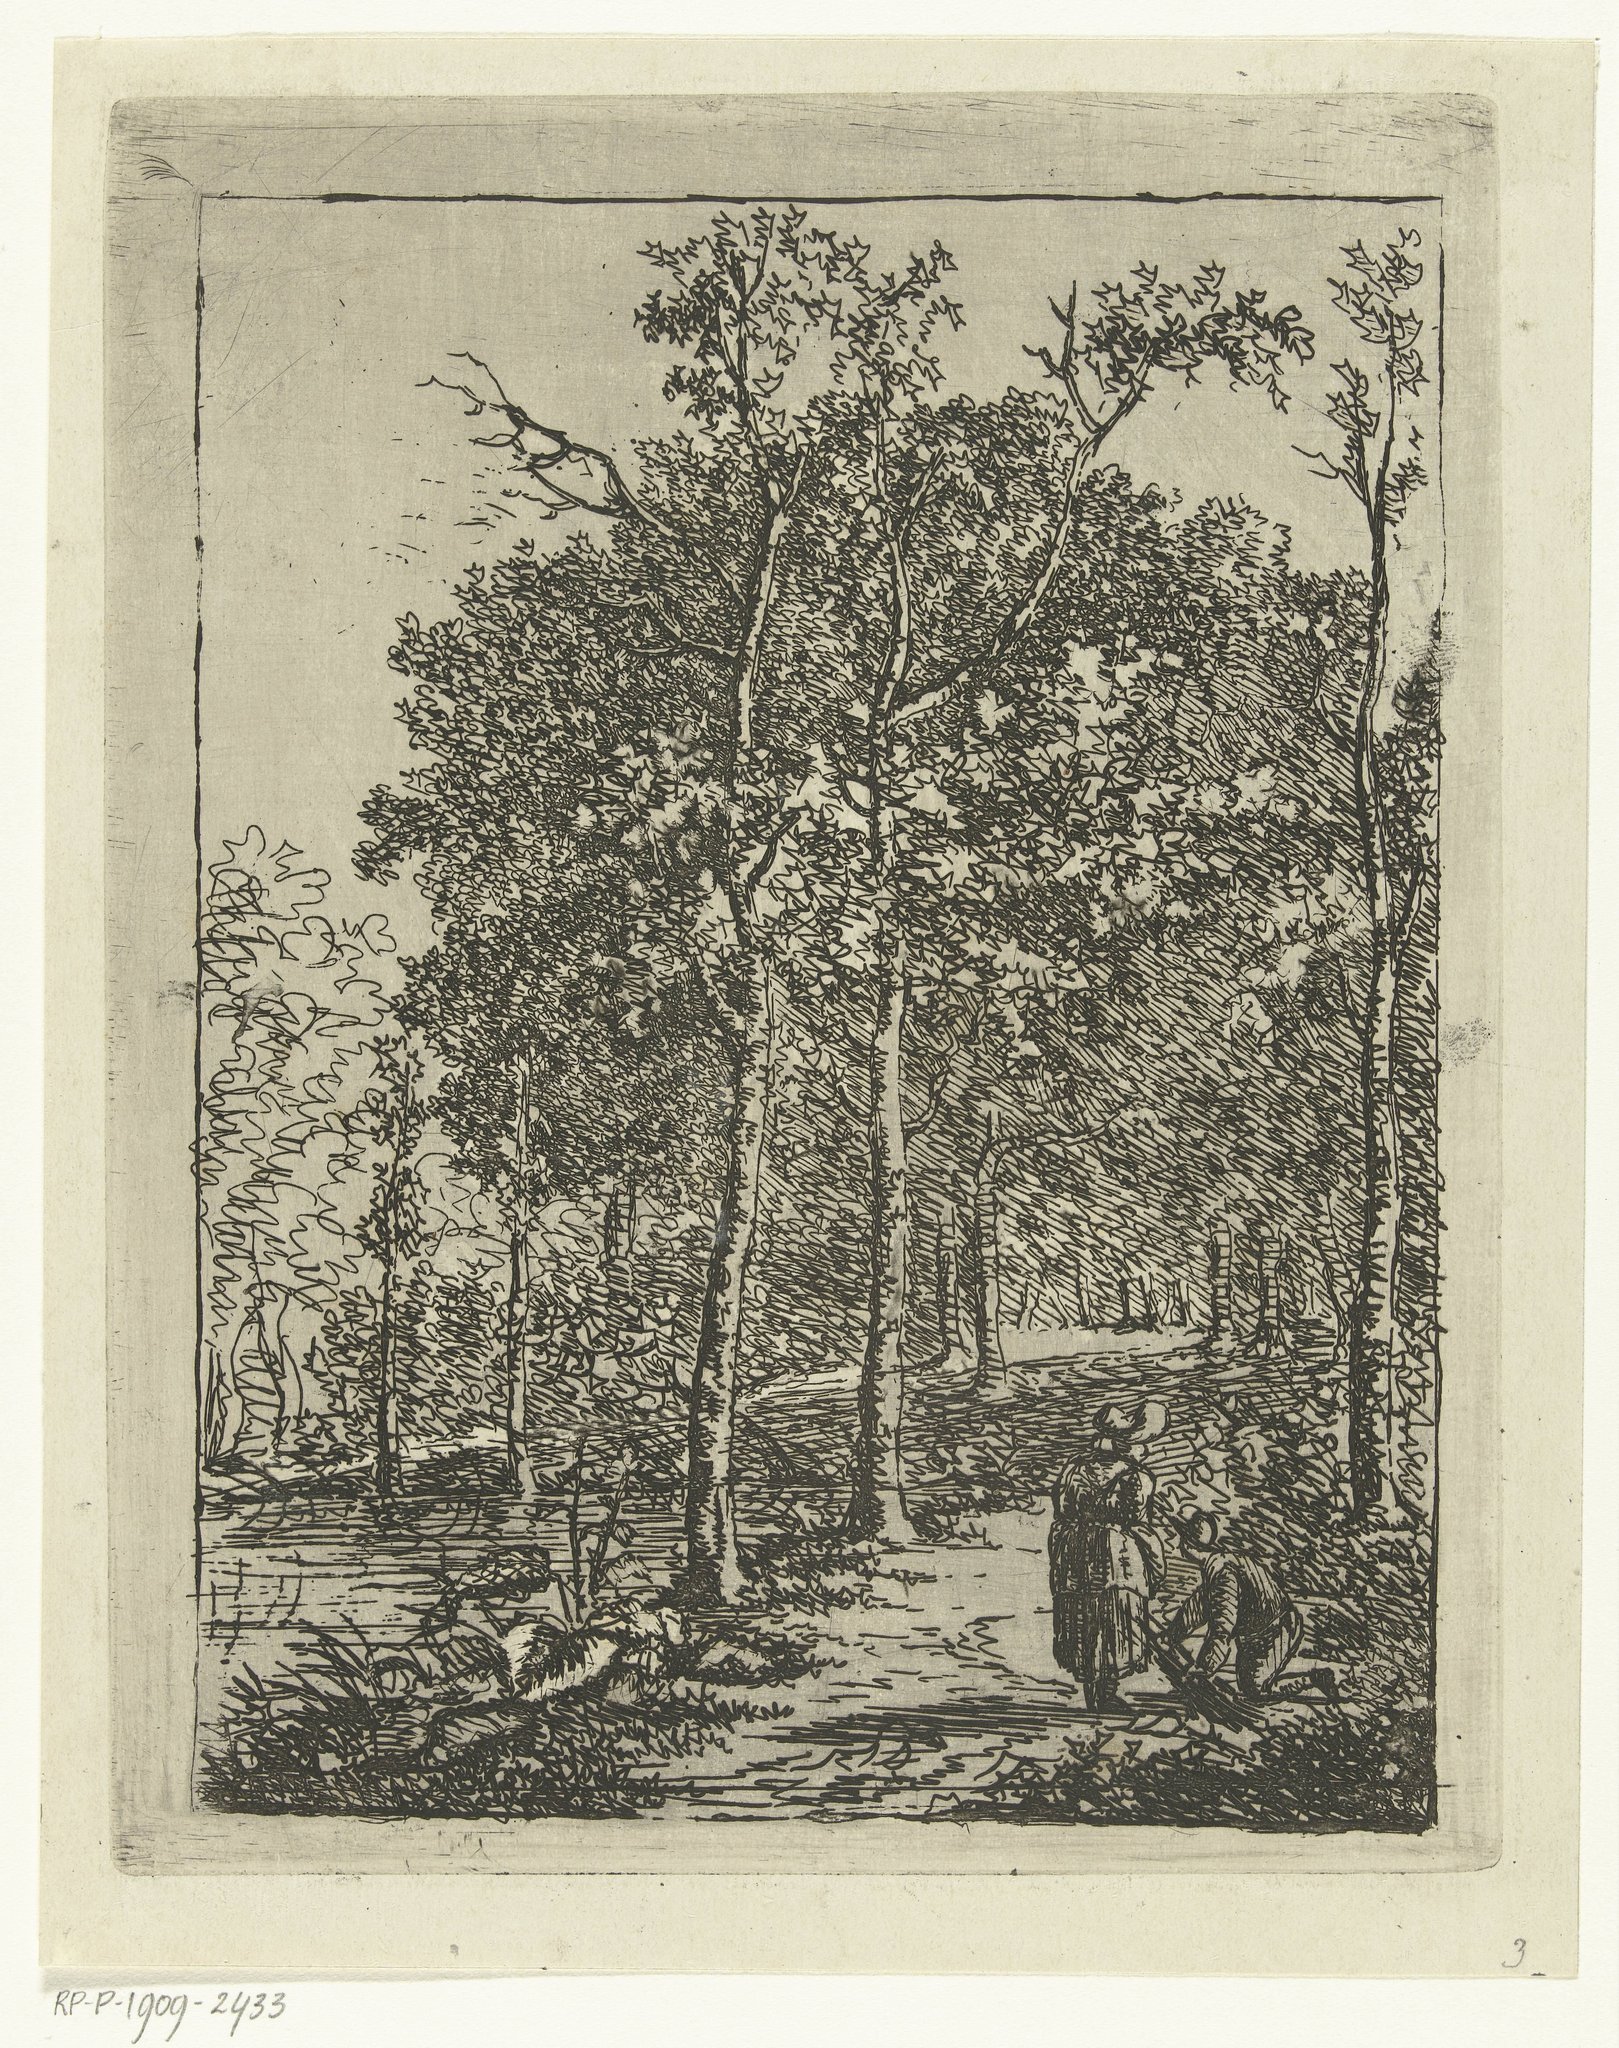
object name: print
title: Gezicht in het Haagse Bos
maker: dirk vis blokhuyzen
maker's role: print maker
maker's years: 1799-1869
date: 1809-1869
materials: paper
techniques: etching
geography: rotterdam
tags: forest, wood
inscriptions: collector's mark: Lugt 1485, collector's mark: Lugt 2228